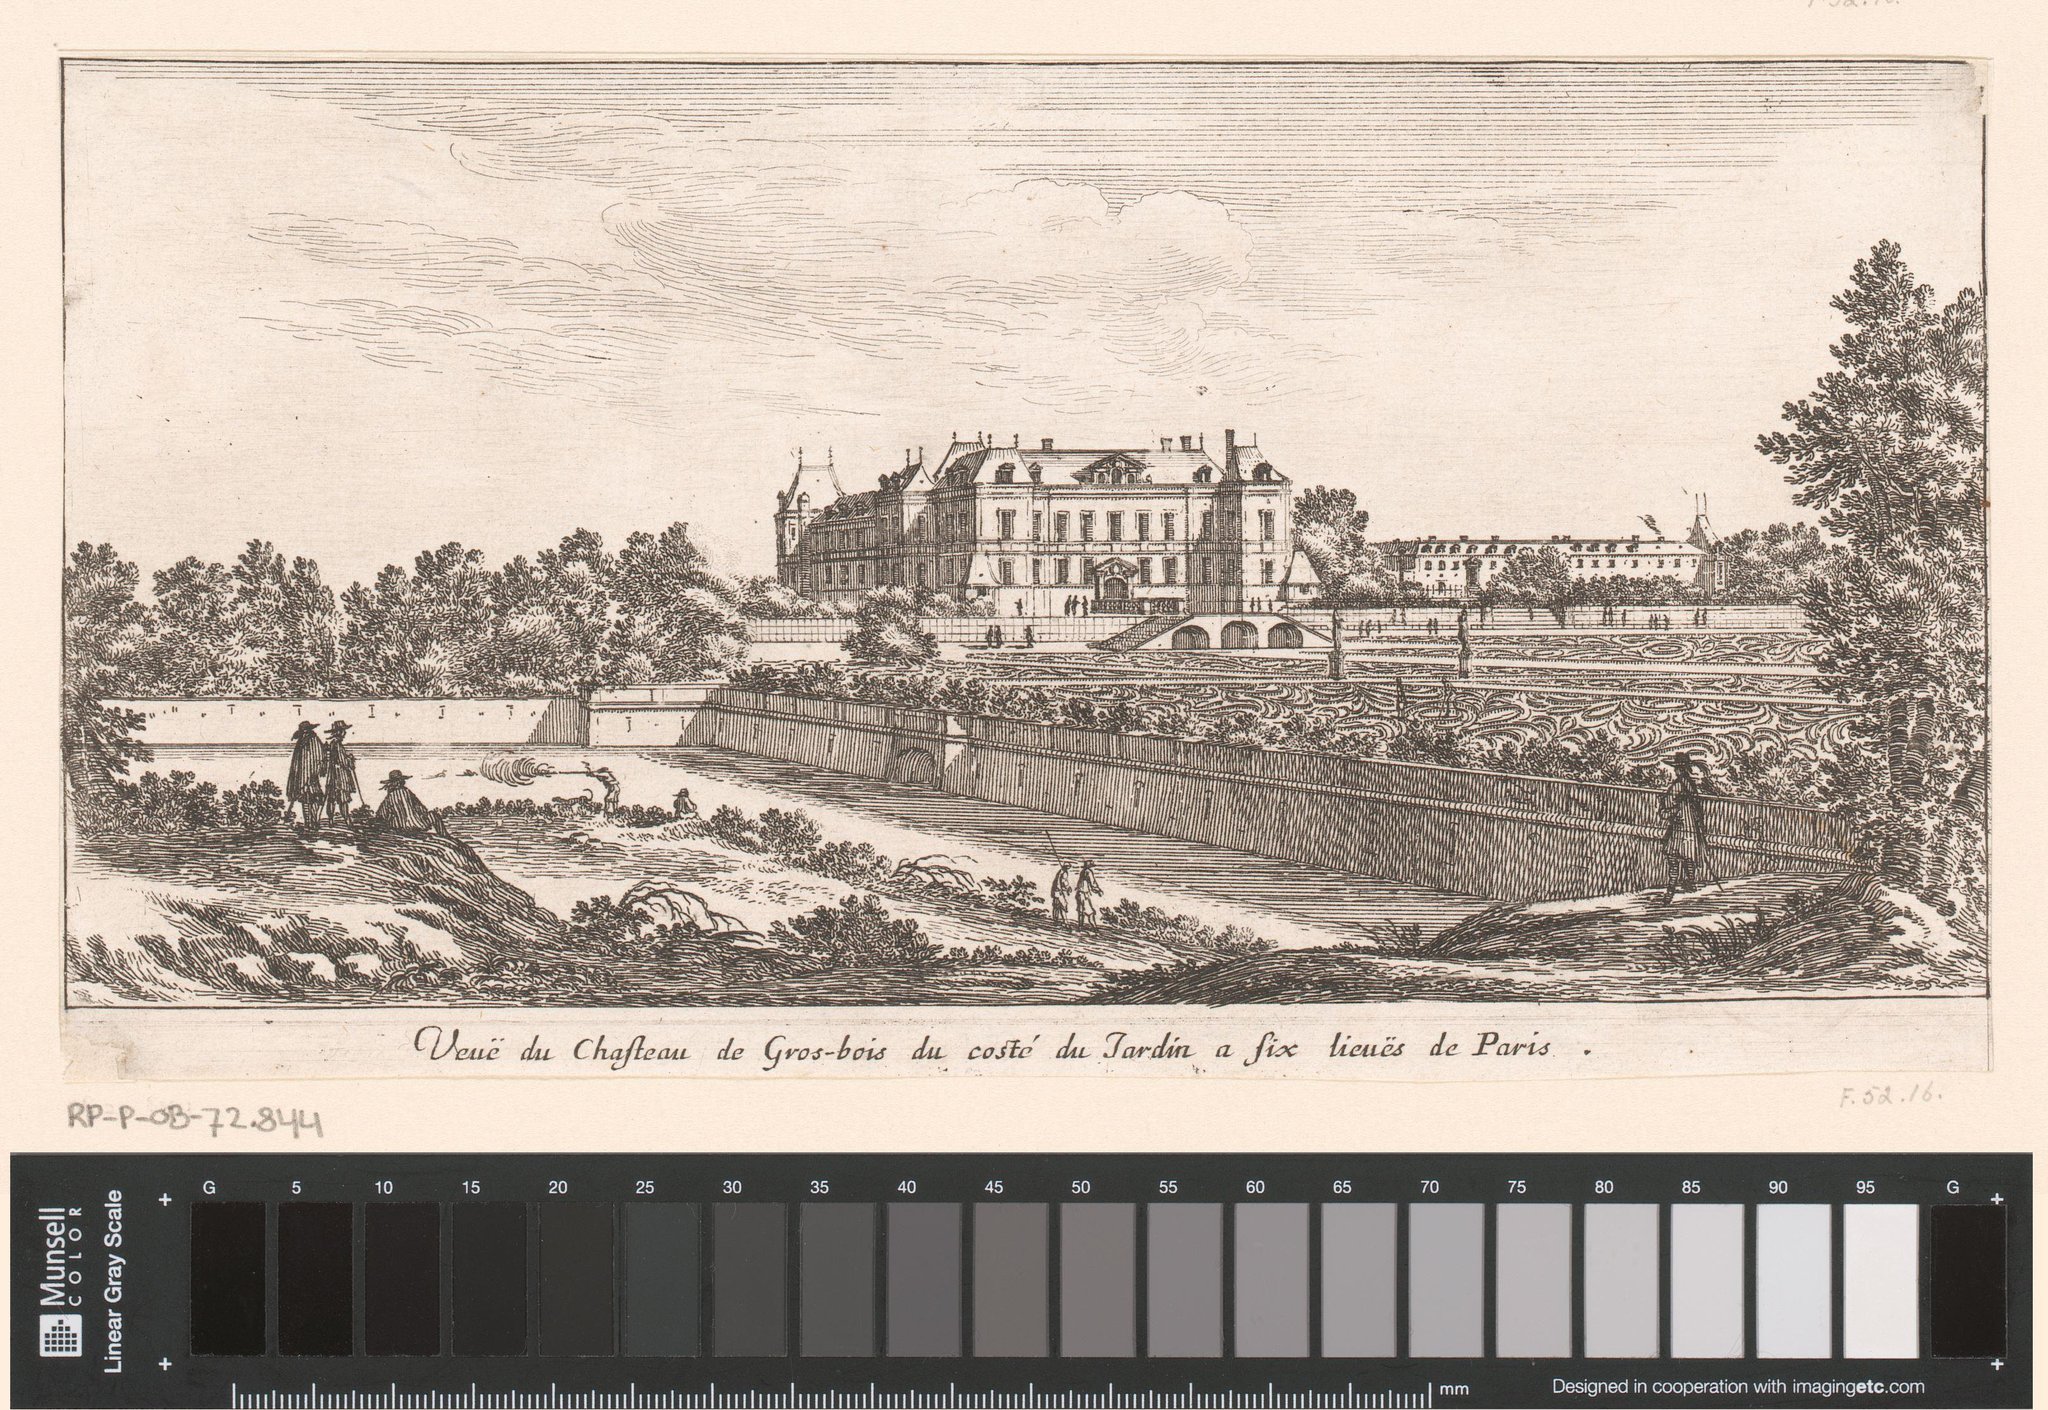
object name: print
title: Livre de diverses Perspectives et Paisages faits sur le naturel, mis en lumière par Israel 1650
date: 1650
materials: paper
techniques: etching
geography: france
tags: french or architectonic garden; formal garden, landscape with tower or castle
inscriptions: collector's mark: Lugt 240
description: Prent maakt deel uit van een ongenummerde serie van zestien prenten.